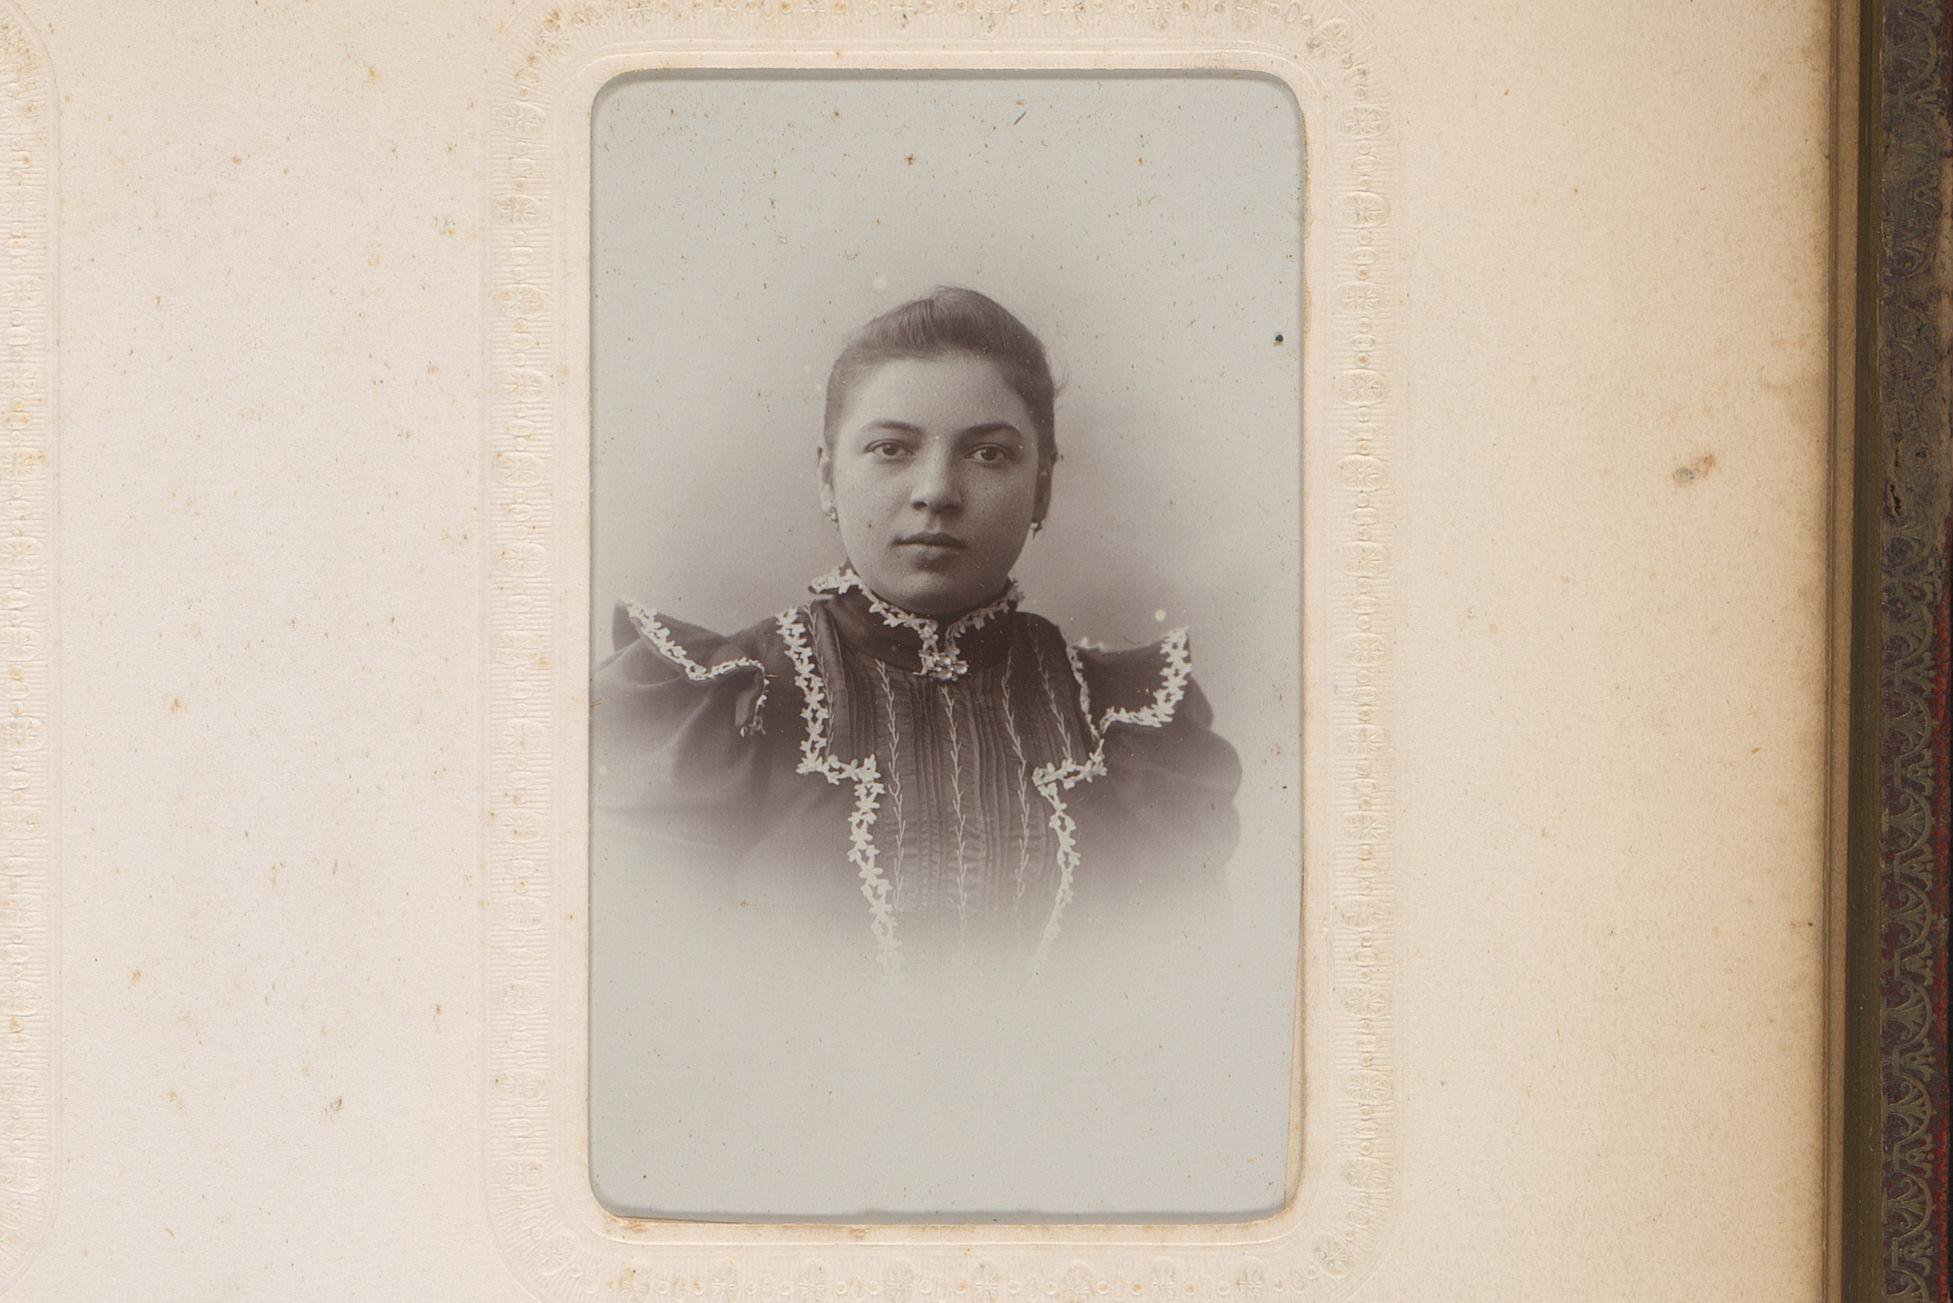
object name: album leaf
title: Portret van een jonge vrouw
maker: Anonymous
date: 1880-1920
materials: cardboard, photographic support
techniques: collodion silver print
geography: netherlands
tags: adolescent, young woman, maiden, historical persons - bb - woman